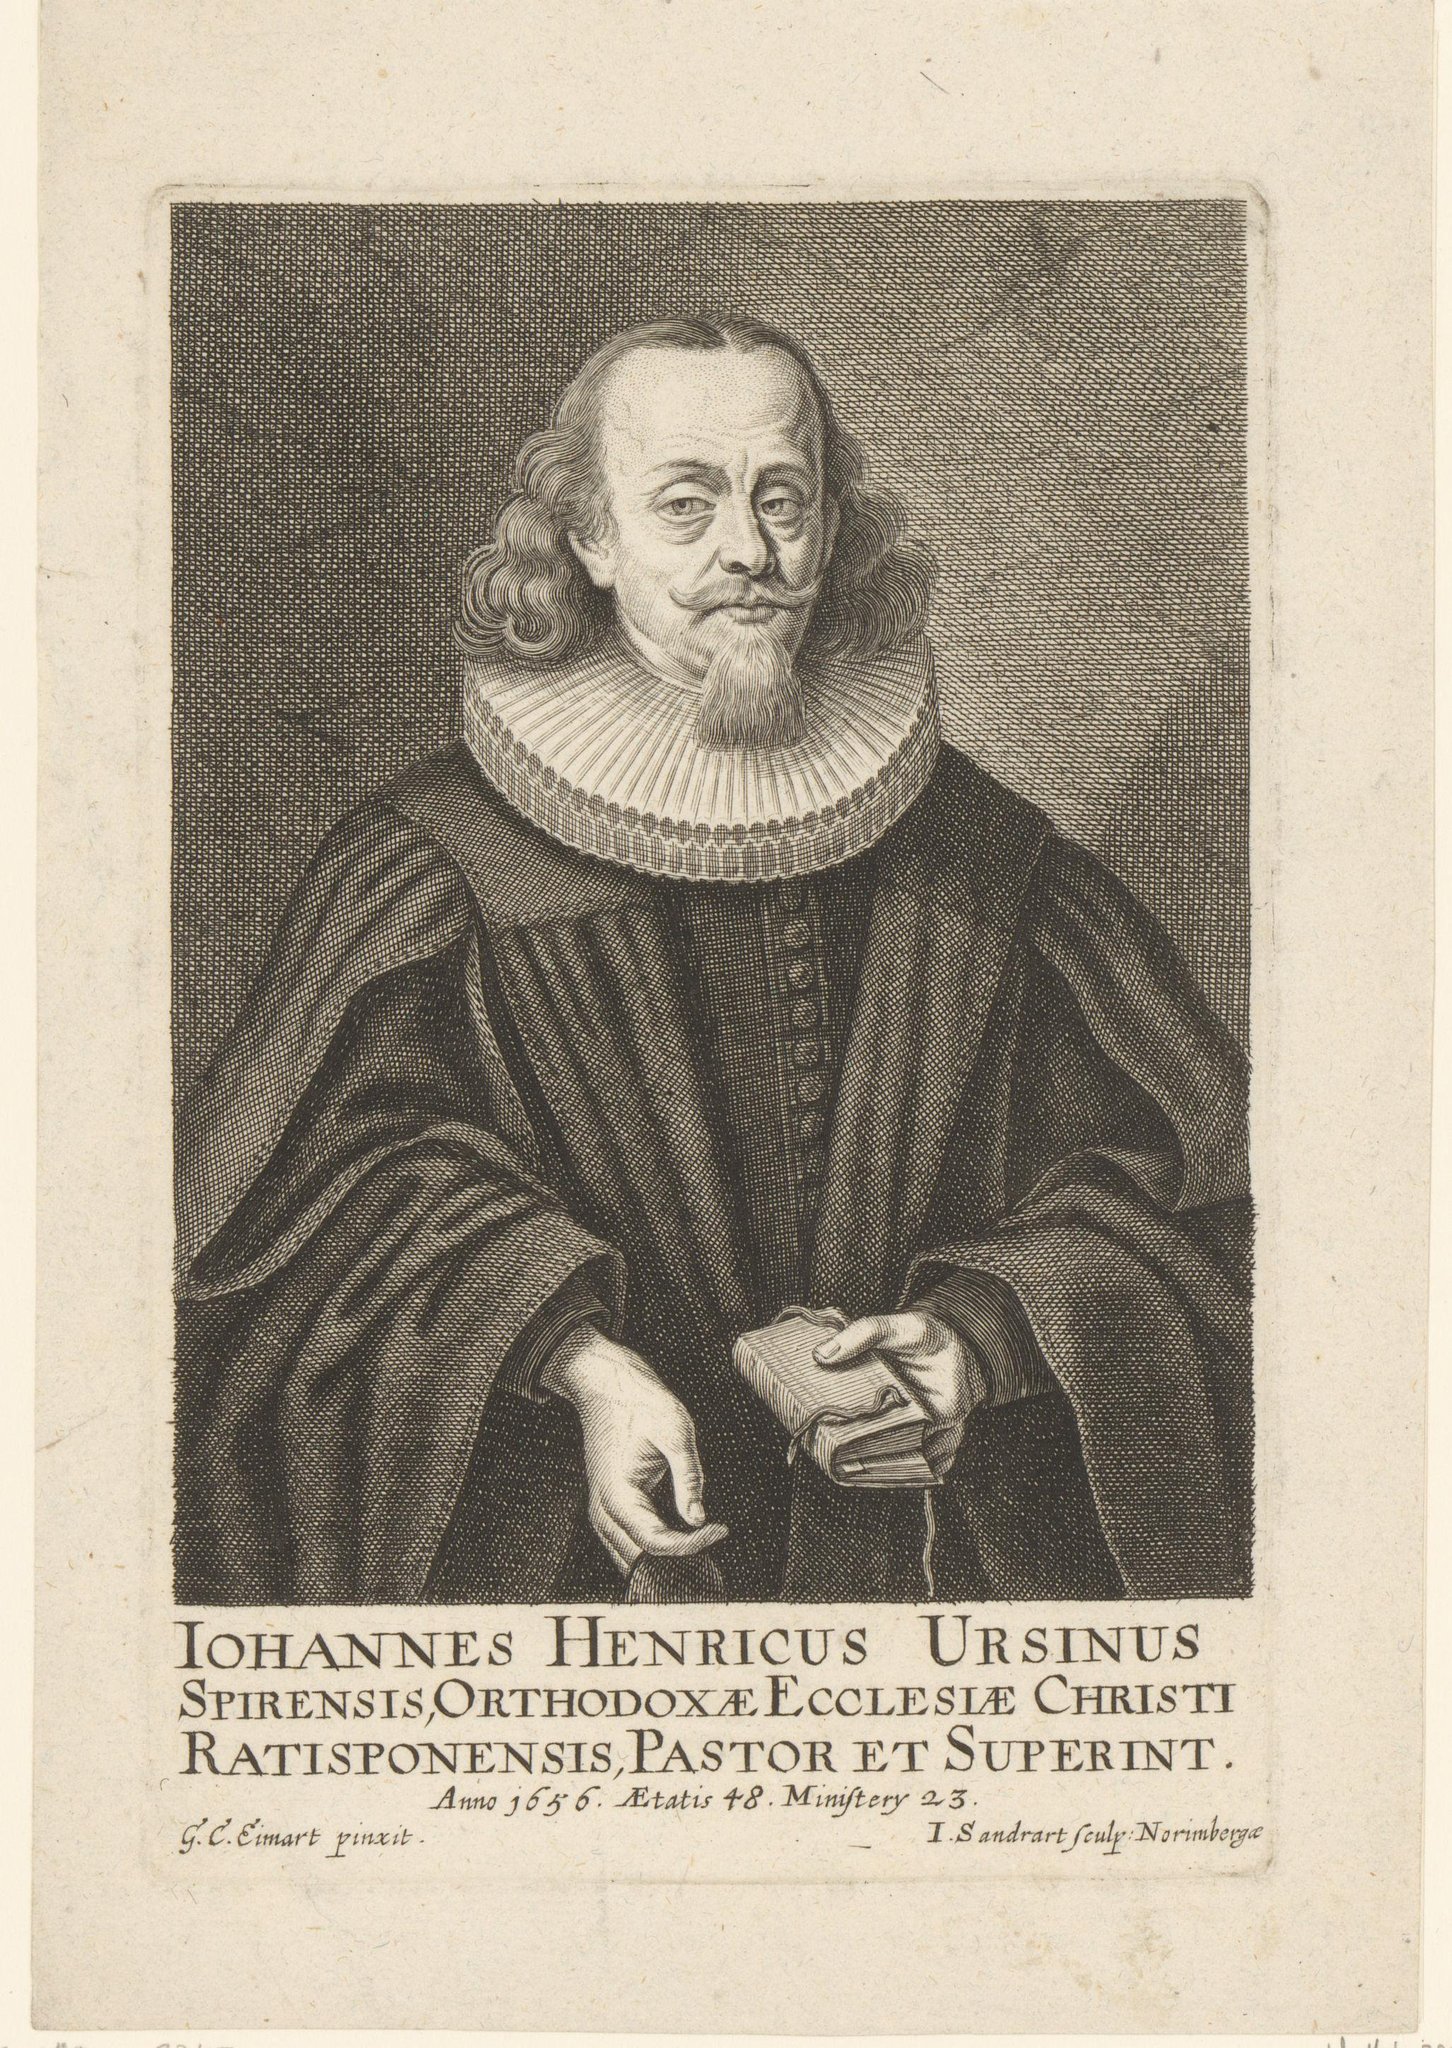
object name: print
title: Portret van Johann Heinrich Ursinus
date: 1656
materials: paper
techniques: engraving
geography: nuremberg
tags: historical persons, book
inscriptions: collector's mark: Lugt 2228